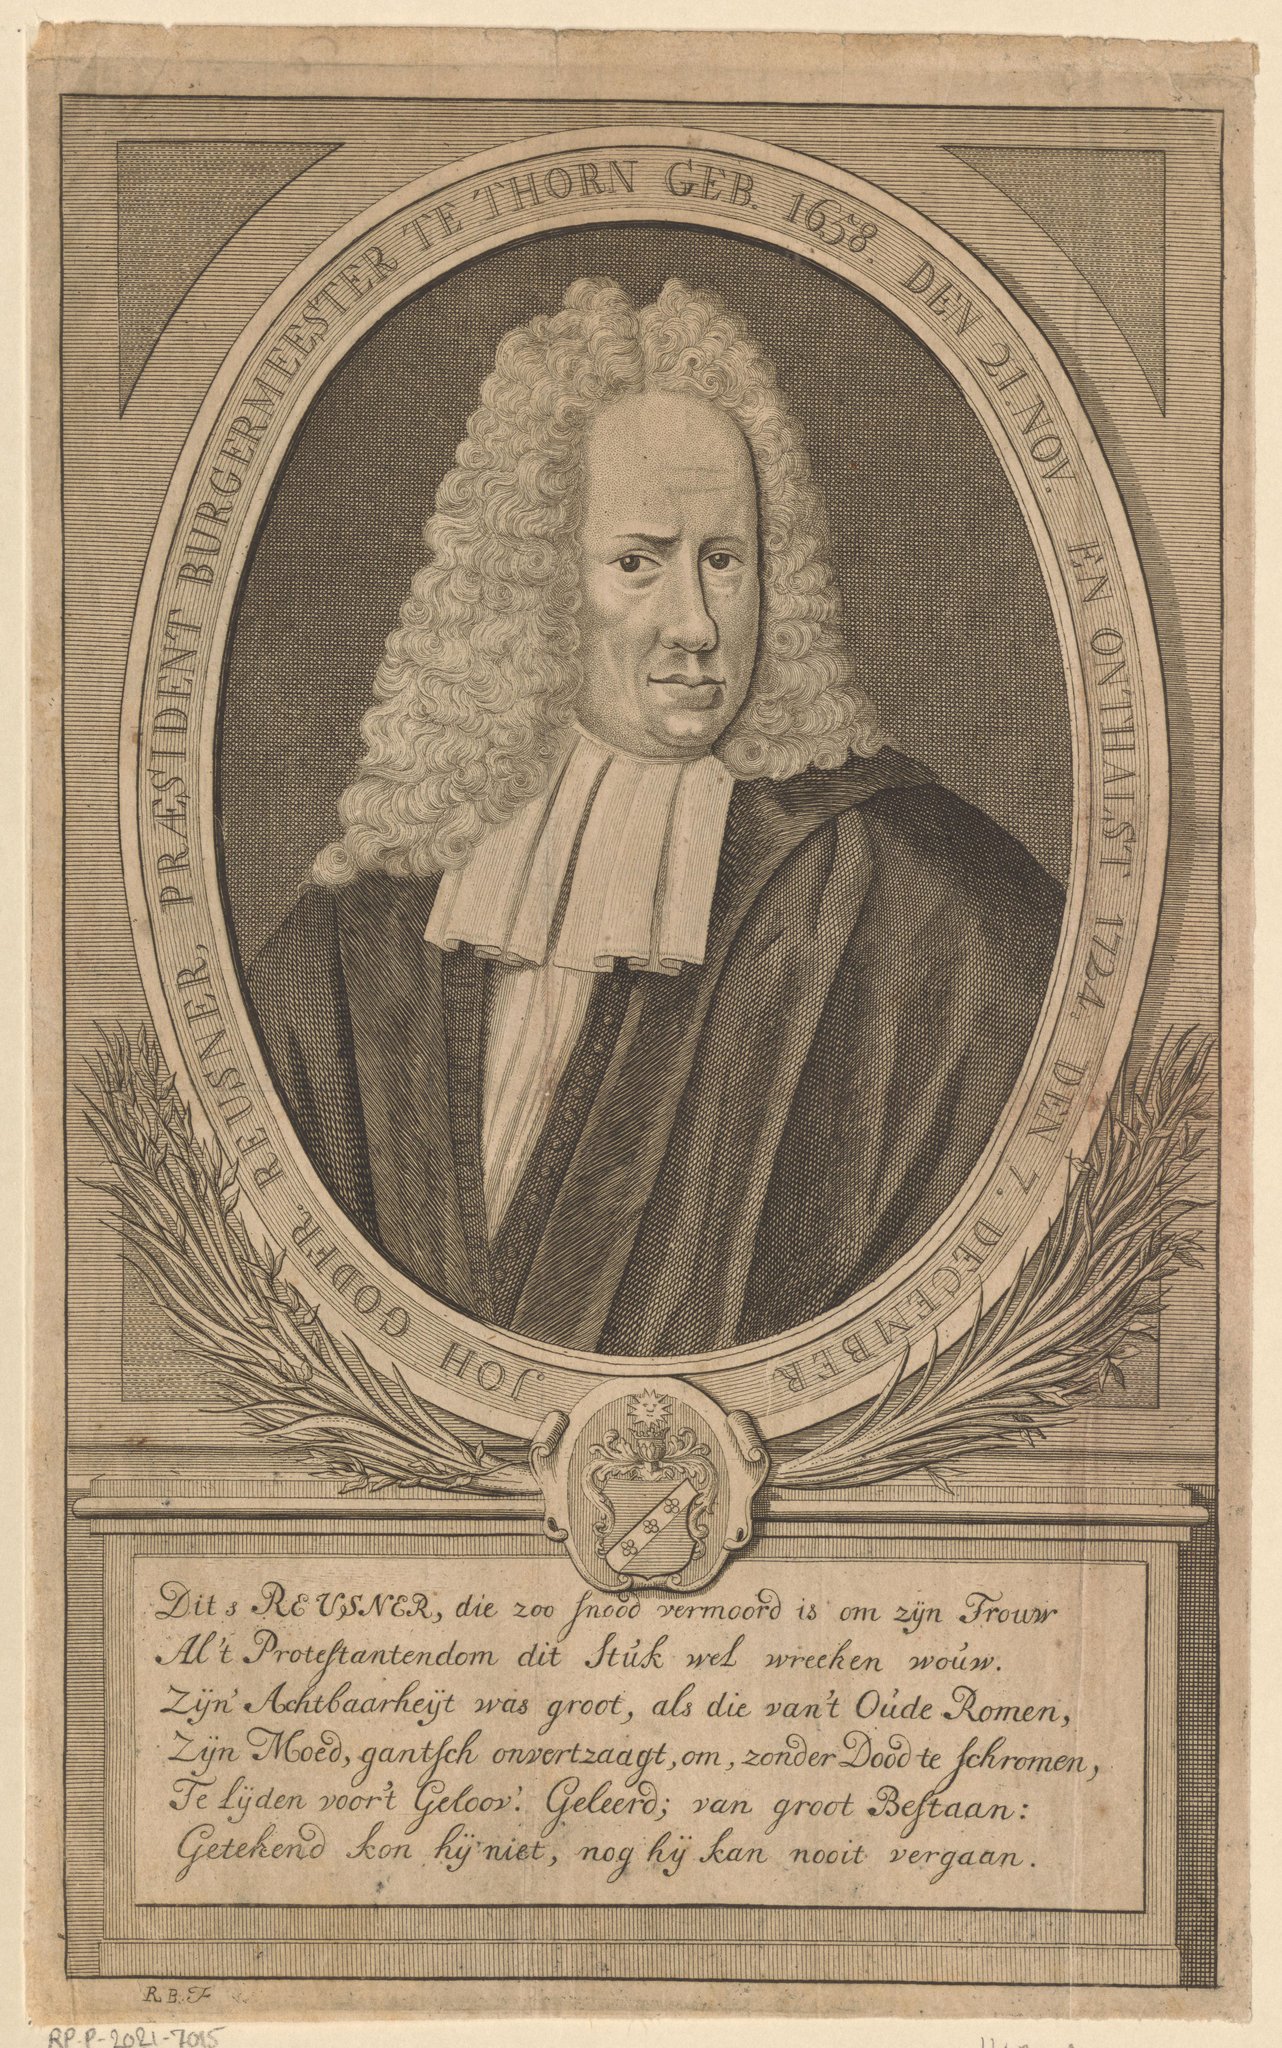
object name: print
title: Portret van Johann Gottfried Roesner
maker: Anonymous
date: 1724-1749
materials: paper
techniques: engraving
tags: historical persons, armorial bearing, heraldry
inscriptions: signature: ‘R.B.’